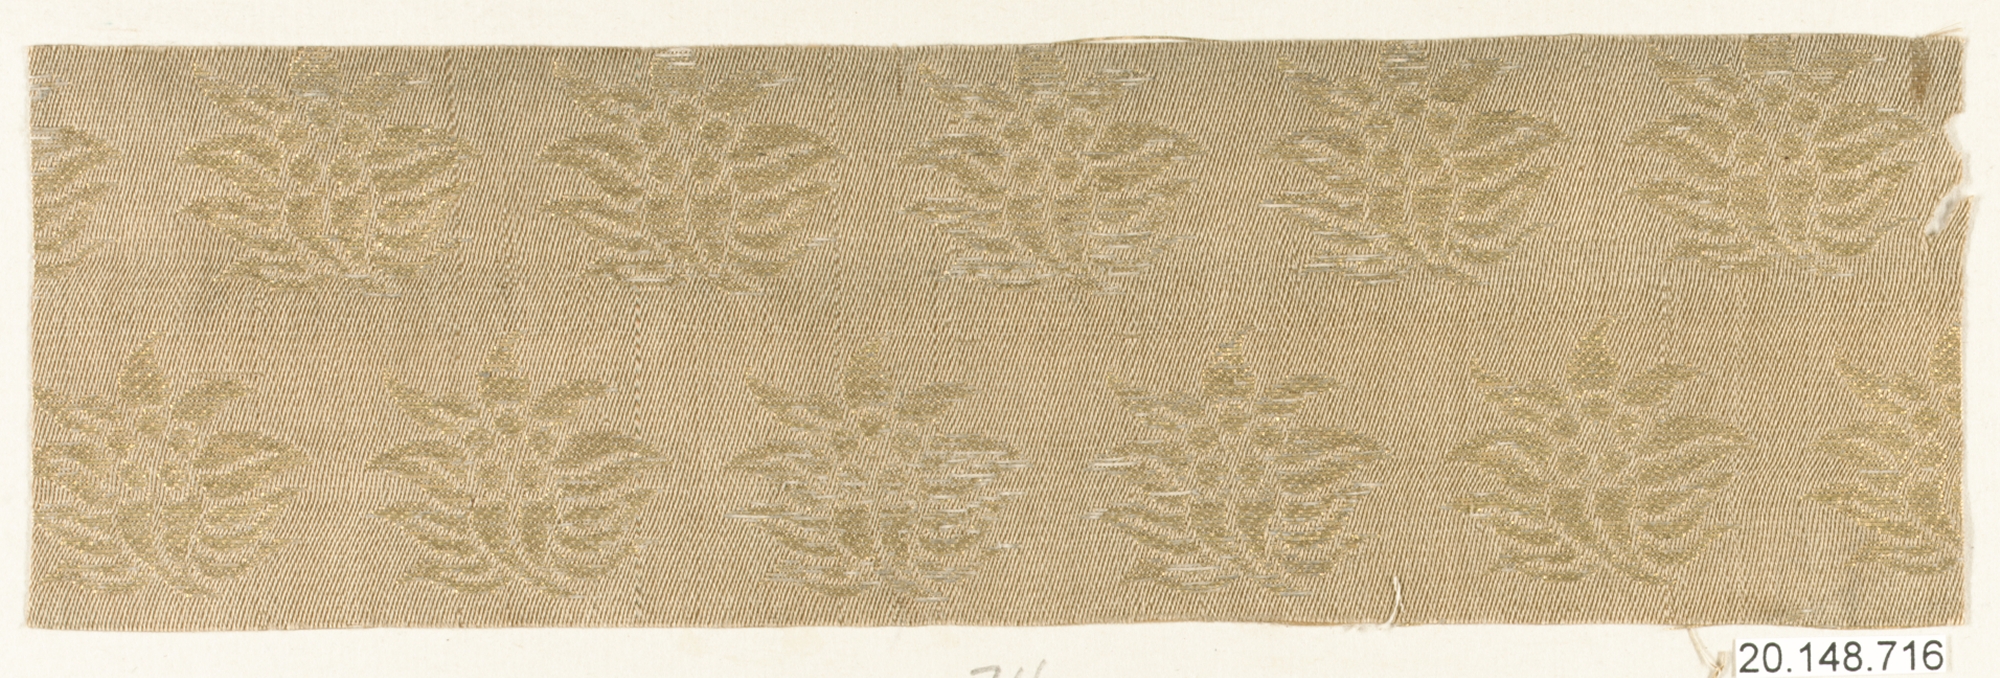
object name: piece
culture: japanese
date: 1701-1800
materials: silk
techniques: compound weave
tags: flowers,leaves